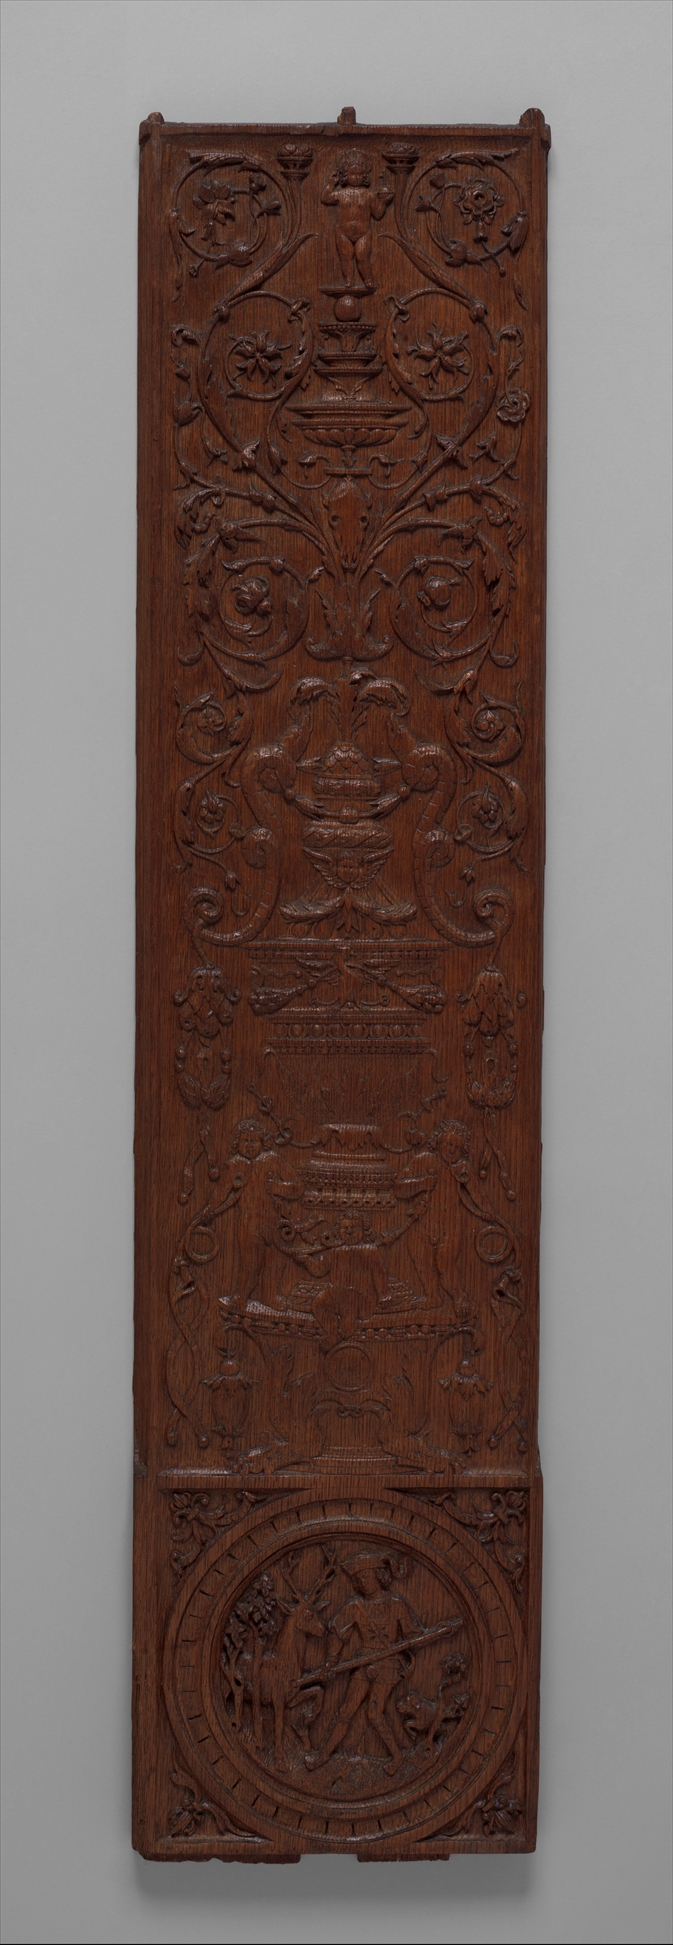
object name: choir screen panel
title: Choir screen panel (one of six)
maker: nicolas castille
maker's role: maker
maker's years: 1503-1521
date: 1508-1510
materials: wood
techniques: carving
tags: men,hunting,deer